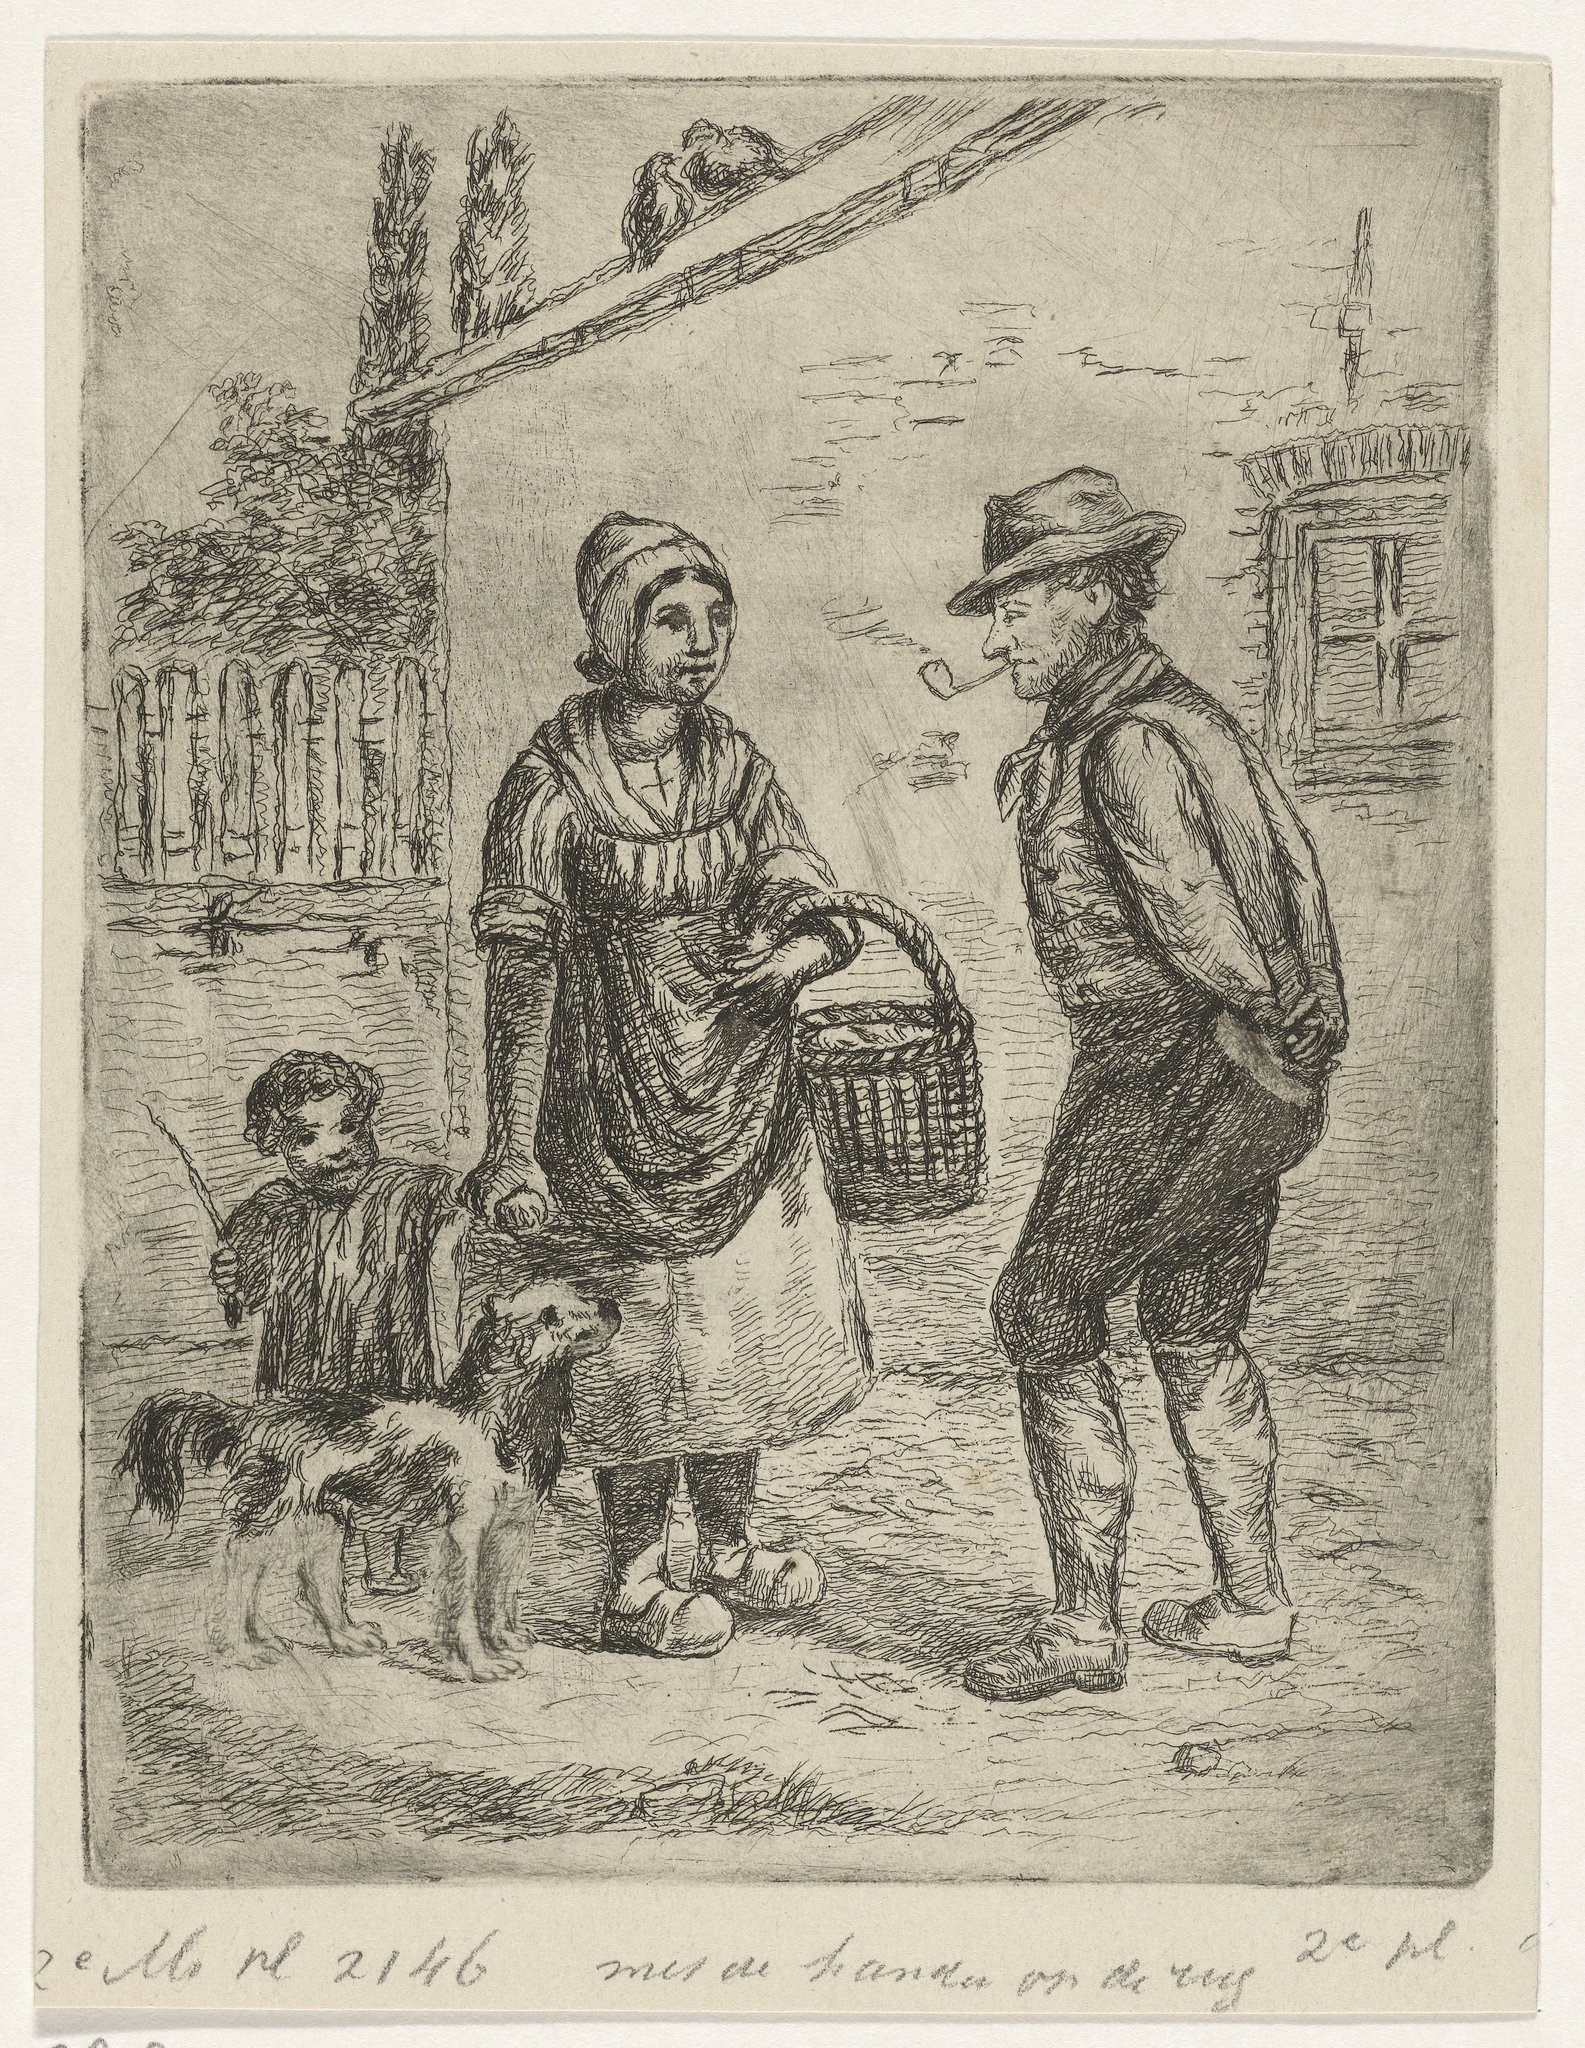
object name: print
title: Boer en boerin bij een hoeve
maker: david van der kellen (1804-1879)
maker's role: die cutter, draughtsman, print maker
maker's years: 1804-1879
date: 1814-1879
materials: paper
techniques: etching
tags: pipe ~ tobacco, farmers - aa - female farmer, farmer's wife, dog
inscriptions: collector's mark: Lugt 2228, inscription: ‘met de handen op de rug 2e pl.’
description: Voor een huis staan een pijprokende man met een wandelstok en hoed en een boerin met een kind aan haar hand. De boerin draagt een mand. Naast hen een hondje en op het dak van het huis zitten twee tortelduiven.